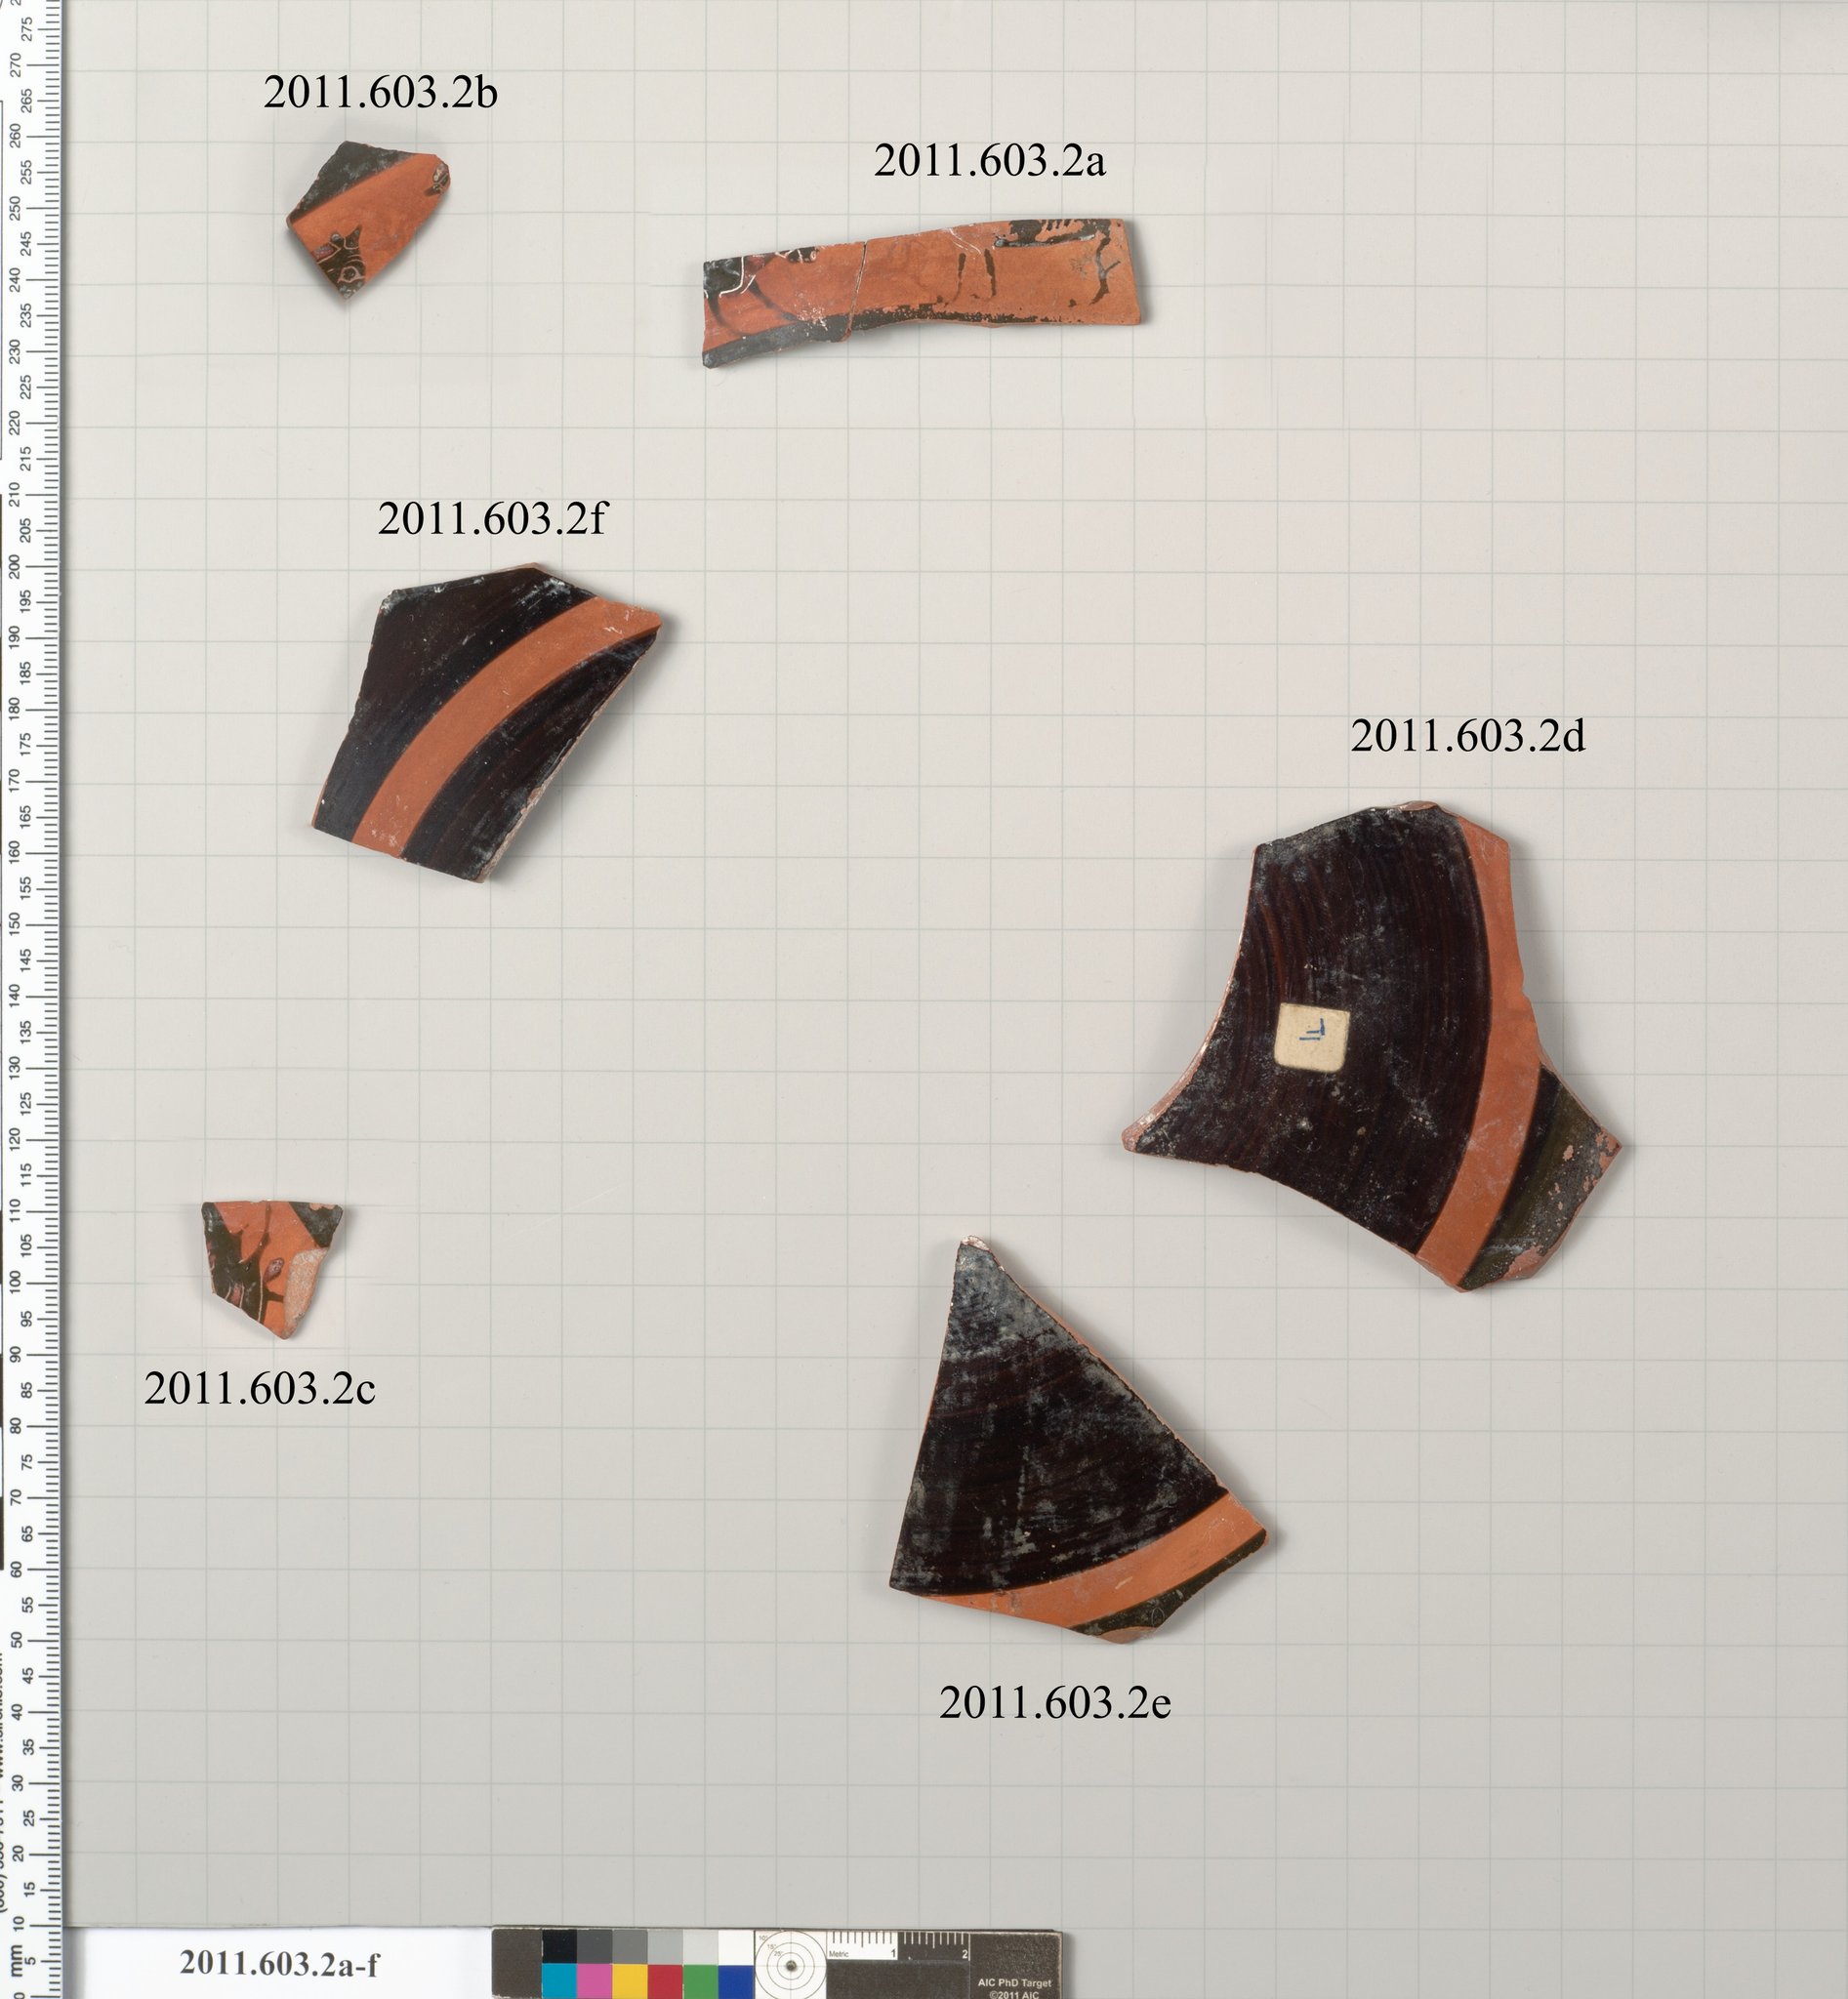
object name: kylix fragment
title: Fragments of a terracotta kylix: band-cup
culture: greek, attic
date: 550-526 BCE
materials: terracotta